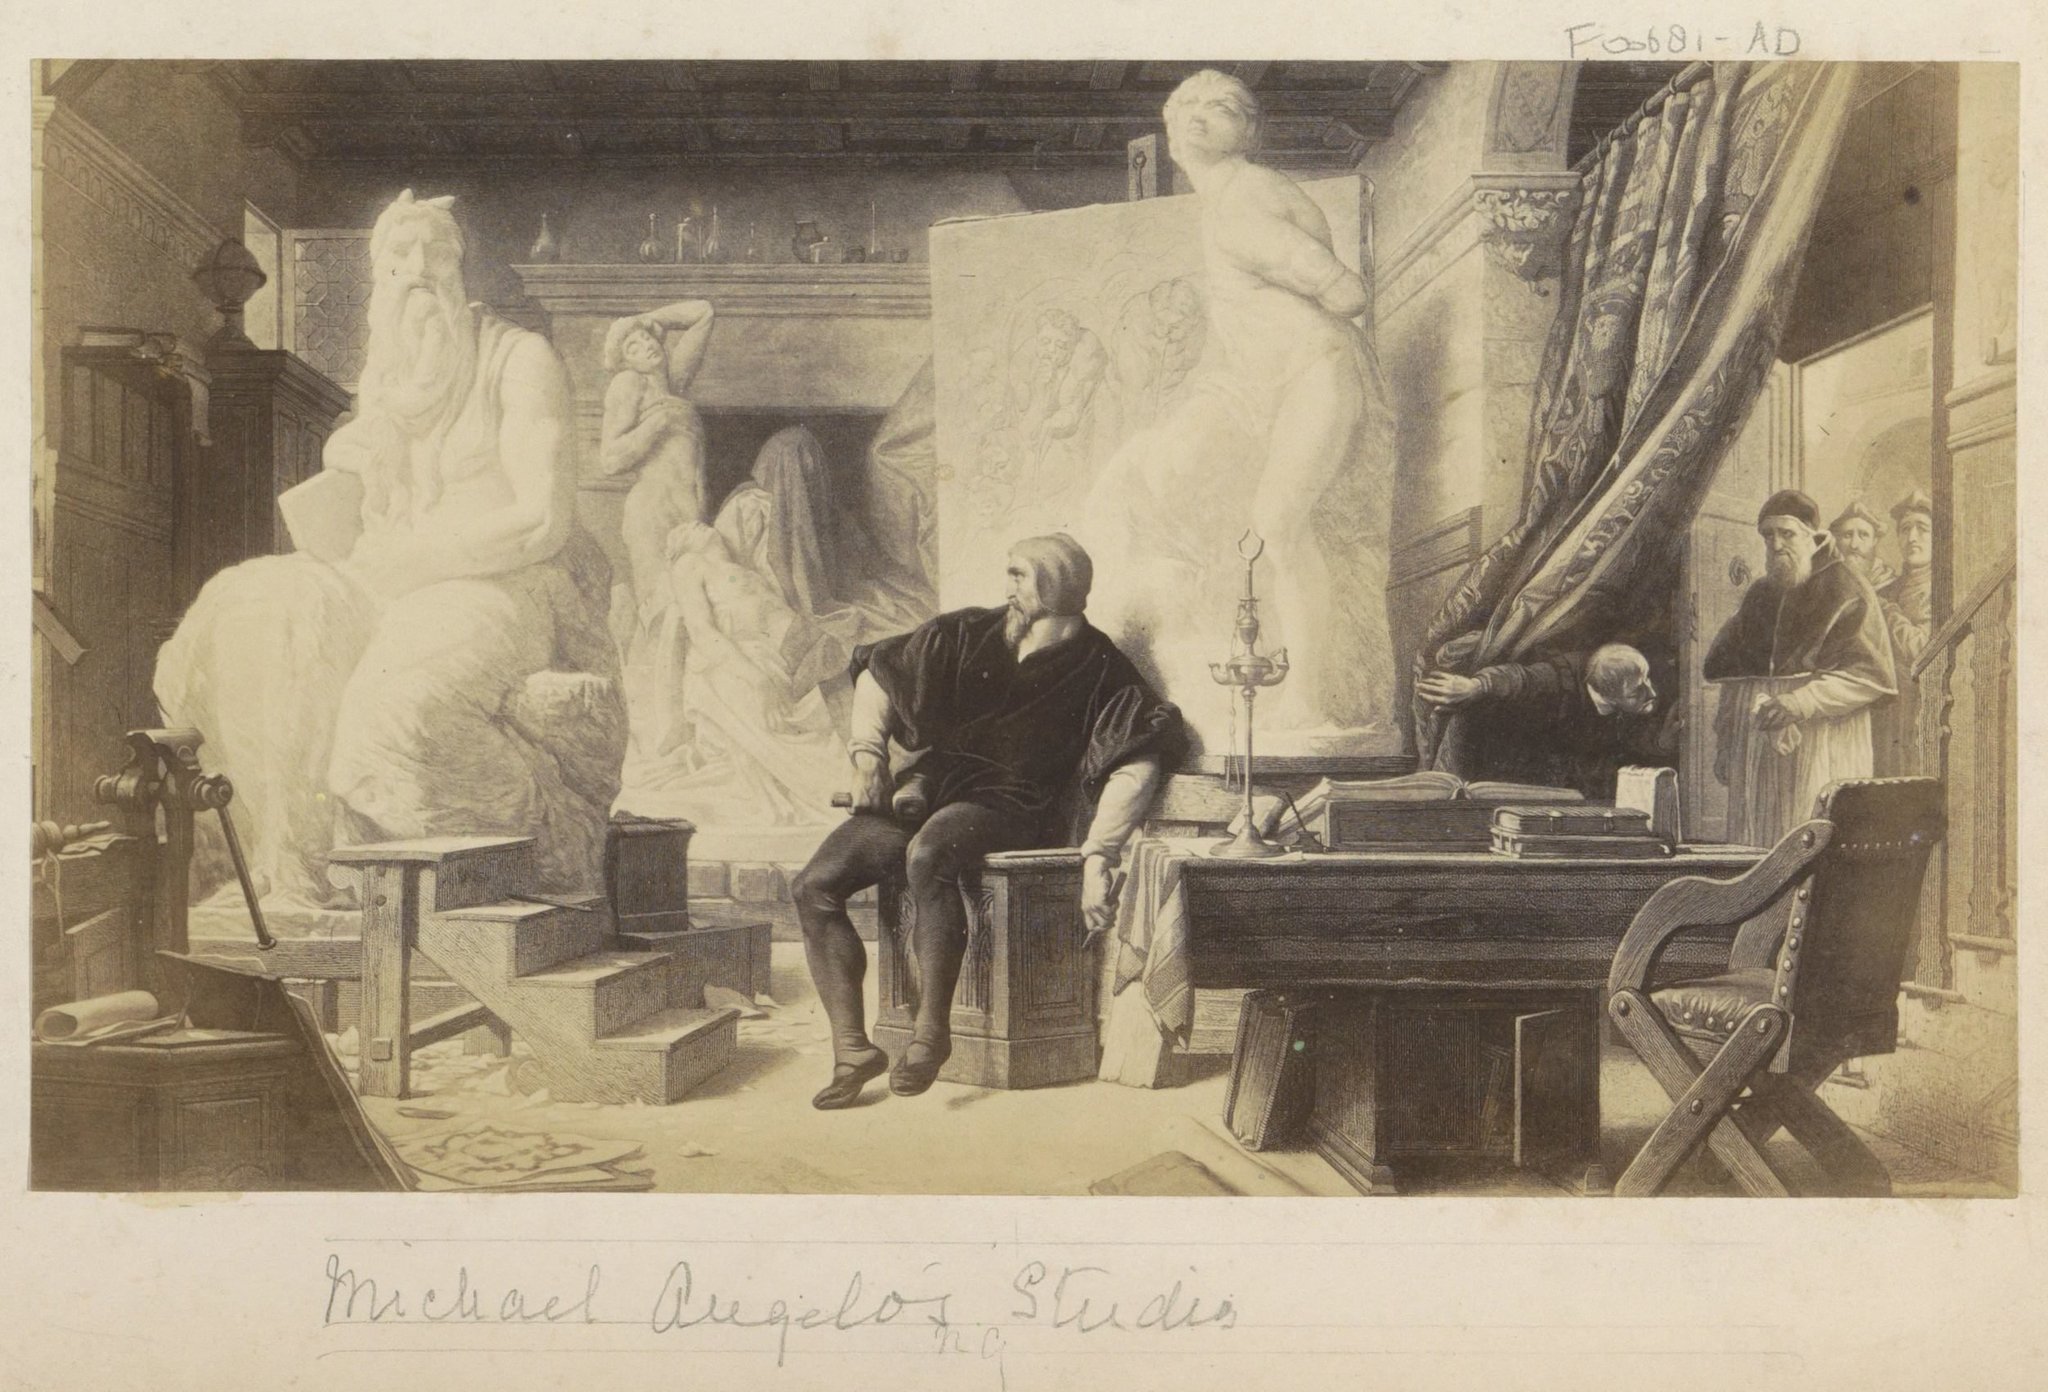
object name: reproduction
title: Fotoreproductie van (vermoedelijk) een tekening voorstellend Michelangelo's studio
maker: Anonymous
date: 1850-1870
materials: paper, photographic support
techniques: albumen print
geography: england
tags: painter at work, in his studio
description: Onderdeel van Album met foto's van bezienswaardigheden en landschappen in Engeland en van kunst.